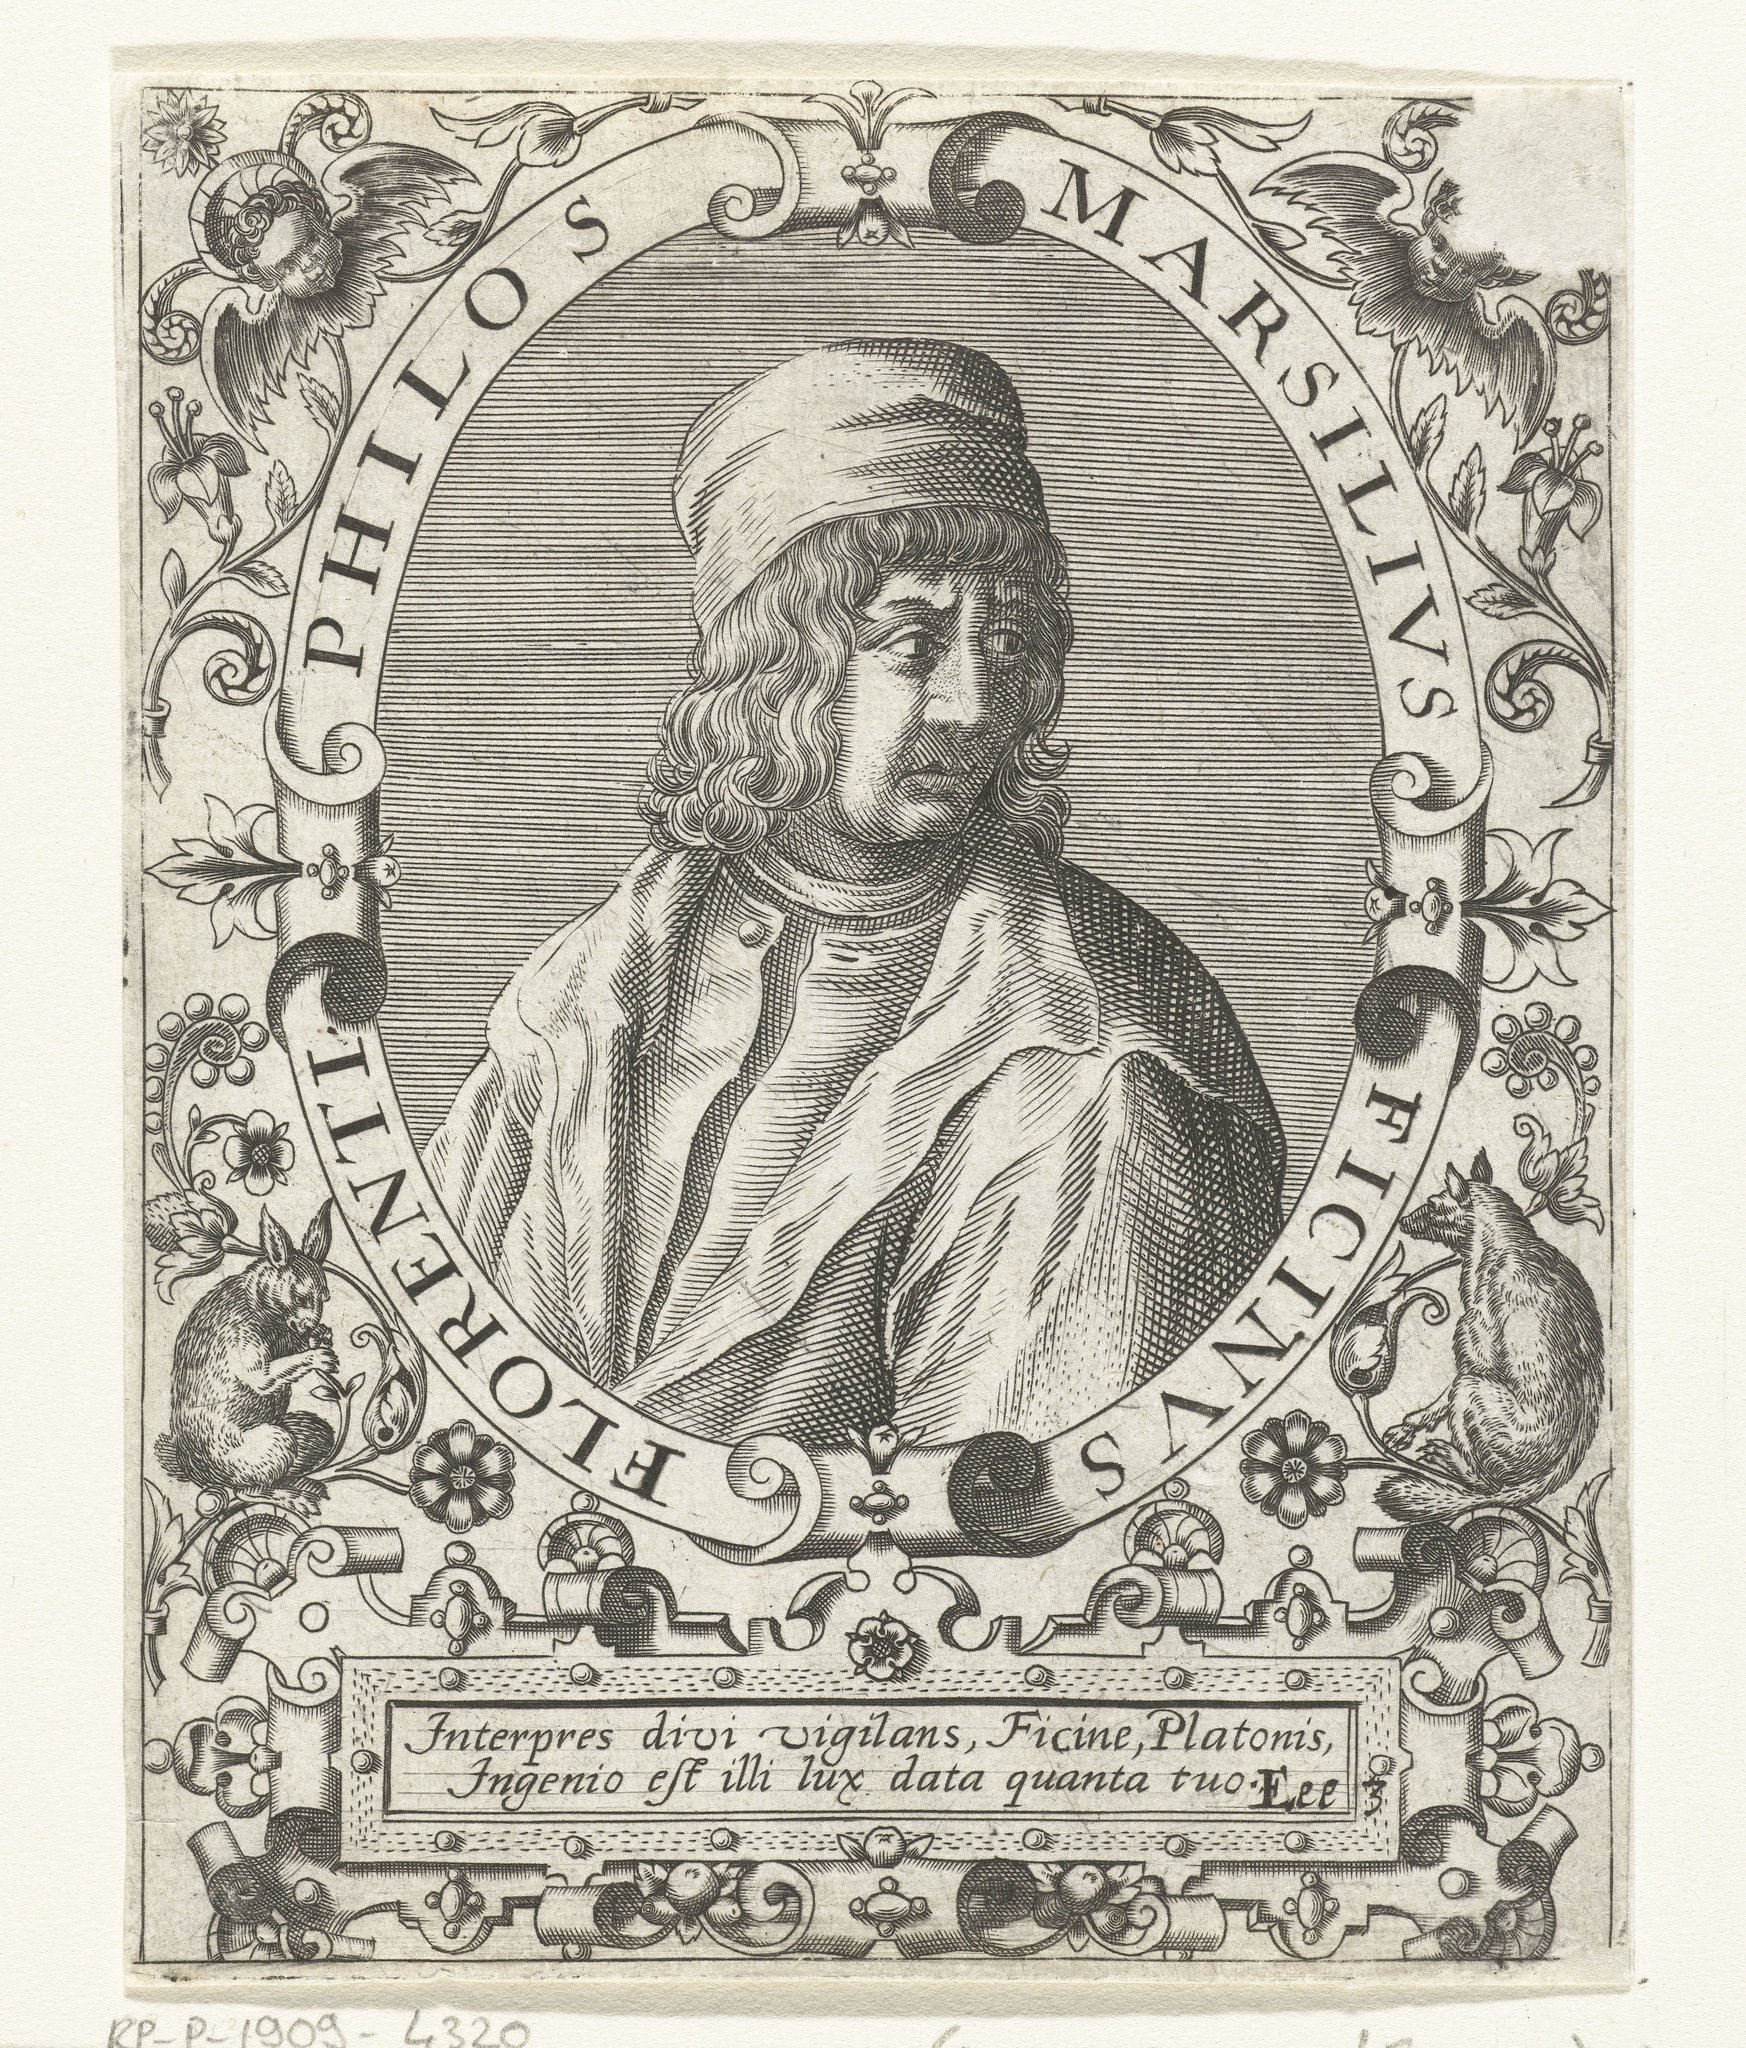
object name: print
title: Portret van Marsilio Ficino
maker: jean jacques boissard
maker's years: 1528-1598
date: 1669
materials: paper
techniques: engraving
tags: figline valdarno, careggi, filosoof, dichter, humanist, vertaler, marsilio ficino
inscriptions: collector's mark: Lugt 2228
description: Gemaakt voor: J.J. Boissard, Icones virorum illustrium doctrina &c eruditione praestanti um contines. Frankfurt am Main: de Bry, 1597-1599. Opnieuw gebruikt in: J.J.Boissard, Bibliotheca chalcographica, hoc est Virtute et eruditione clarorum Virorum Imagines. Heidelberg: Clemens Ammon, 1669 (te herkennen aan de toegevoegde signatuur in de rechter onderhoek: 2B2).